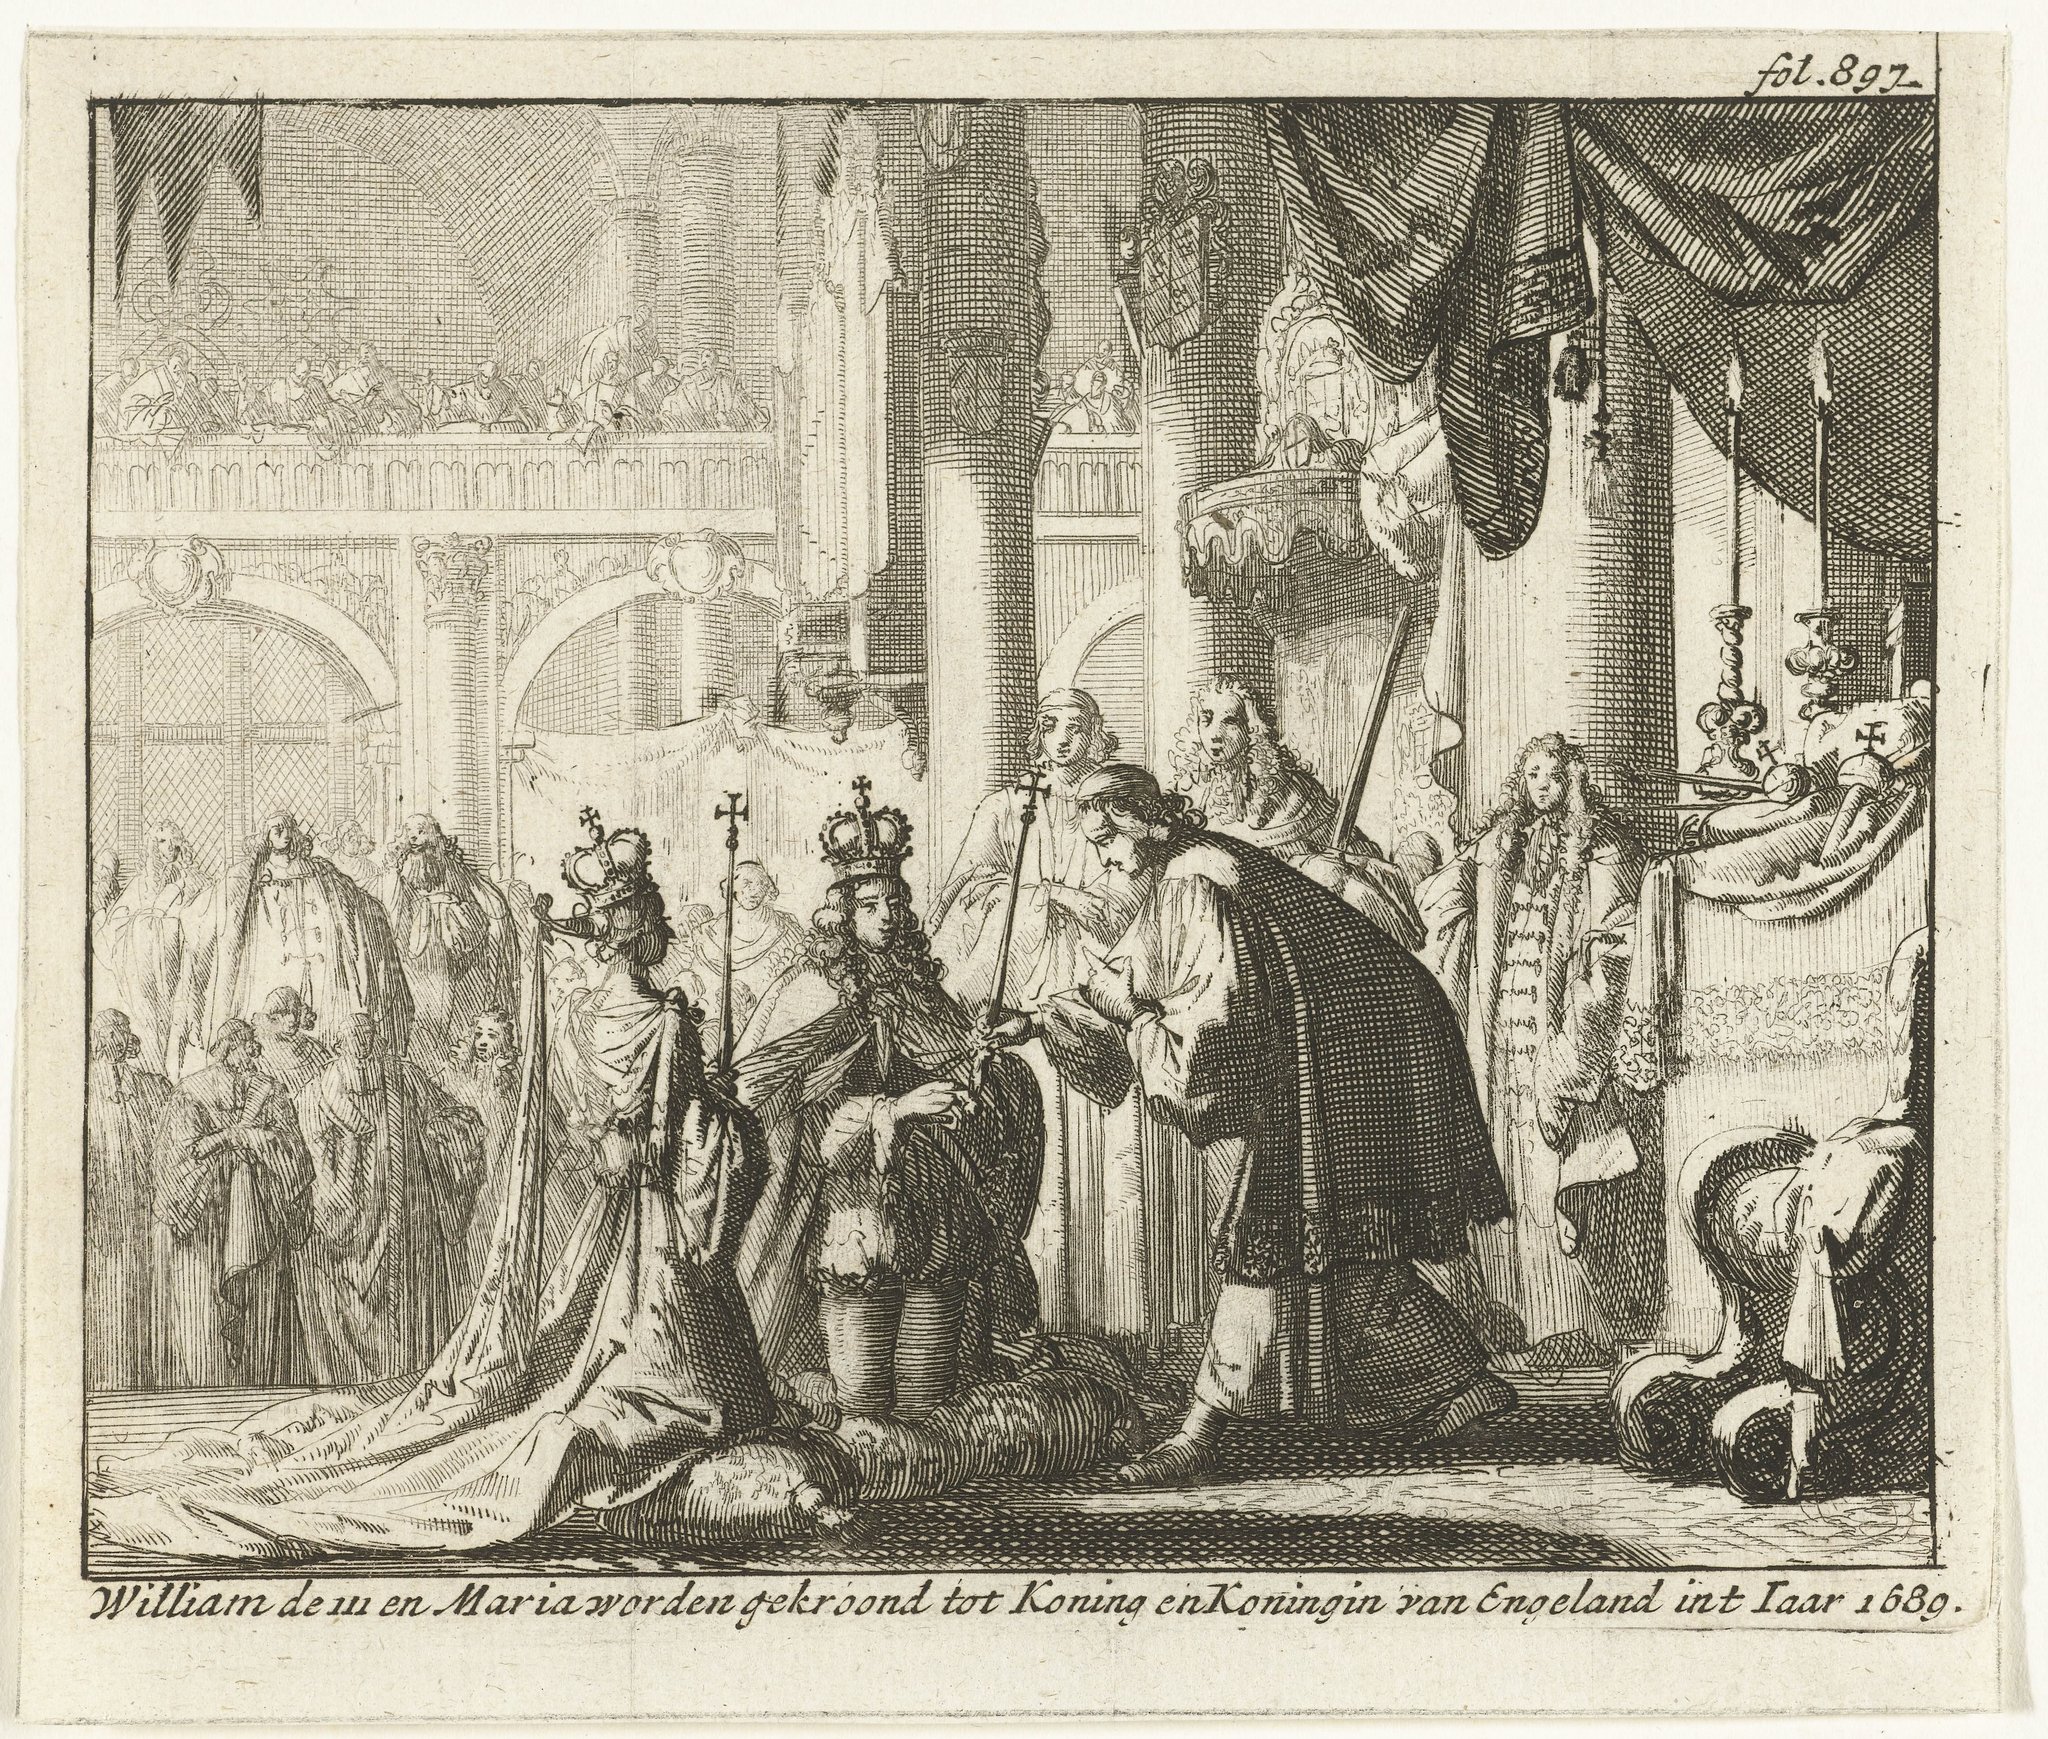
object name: print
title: Kroning van Willem III en Maria II, 1689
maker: jan luyken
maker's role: draughtsman, print maker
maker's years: 1649-1712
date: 1689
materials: paper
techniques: engraving, etching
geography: northern netherlands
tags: the hague, william iii (prince of orange and king of england, scotland, and ireland), london, maria ii stuart (koningin van engeland, schotland en ierland), during the coronation, westminster abbey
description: Gebruikt als illustratie in: D.P. Pers, Romeynschen adelaer, 3 dln, Jurriaen van Poolsum, Utrecht 1689, fol. 897. Deze prent is ook genummerd FMH 2696 als illustratie voor: Lambert van den Bosch, Het leven en bedryf van Willem de Darde, Jan Claesz ten Hoorn, Amsterdam 1694, 4 delen.